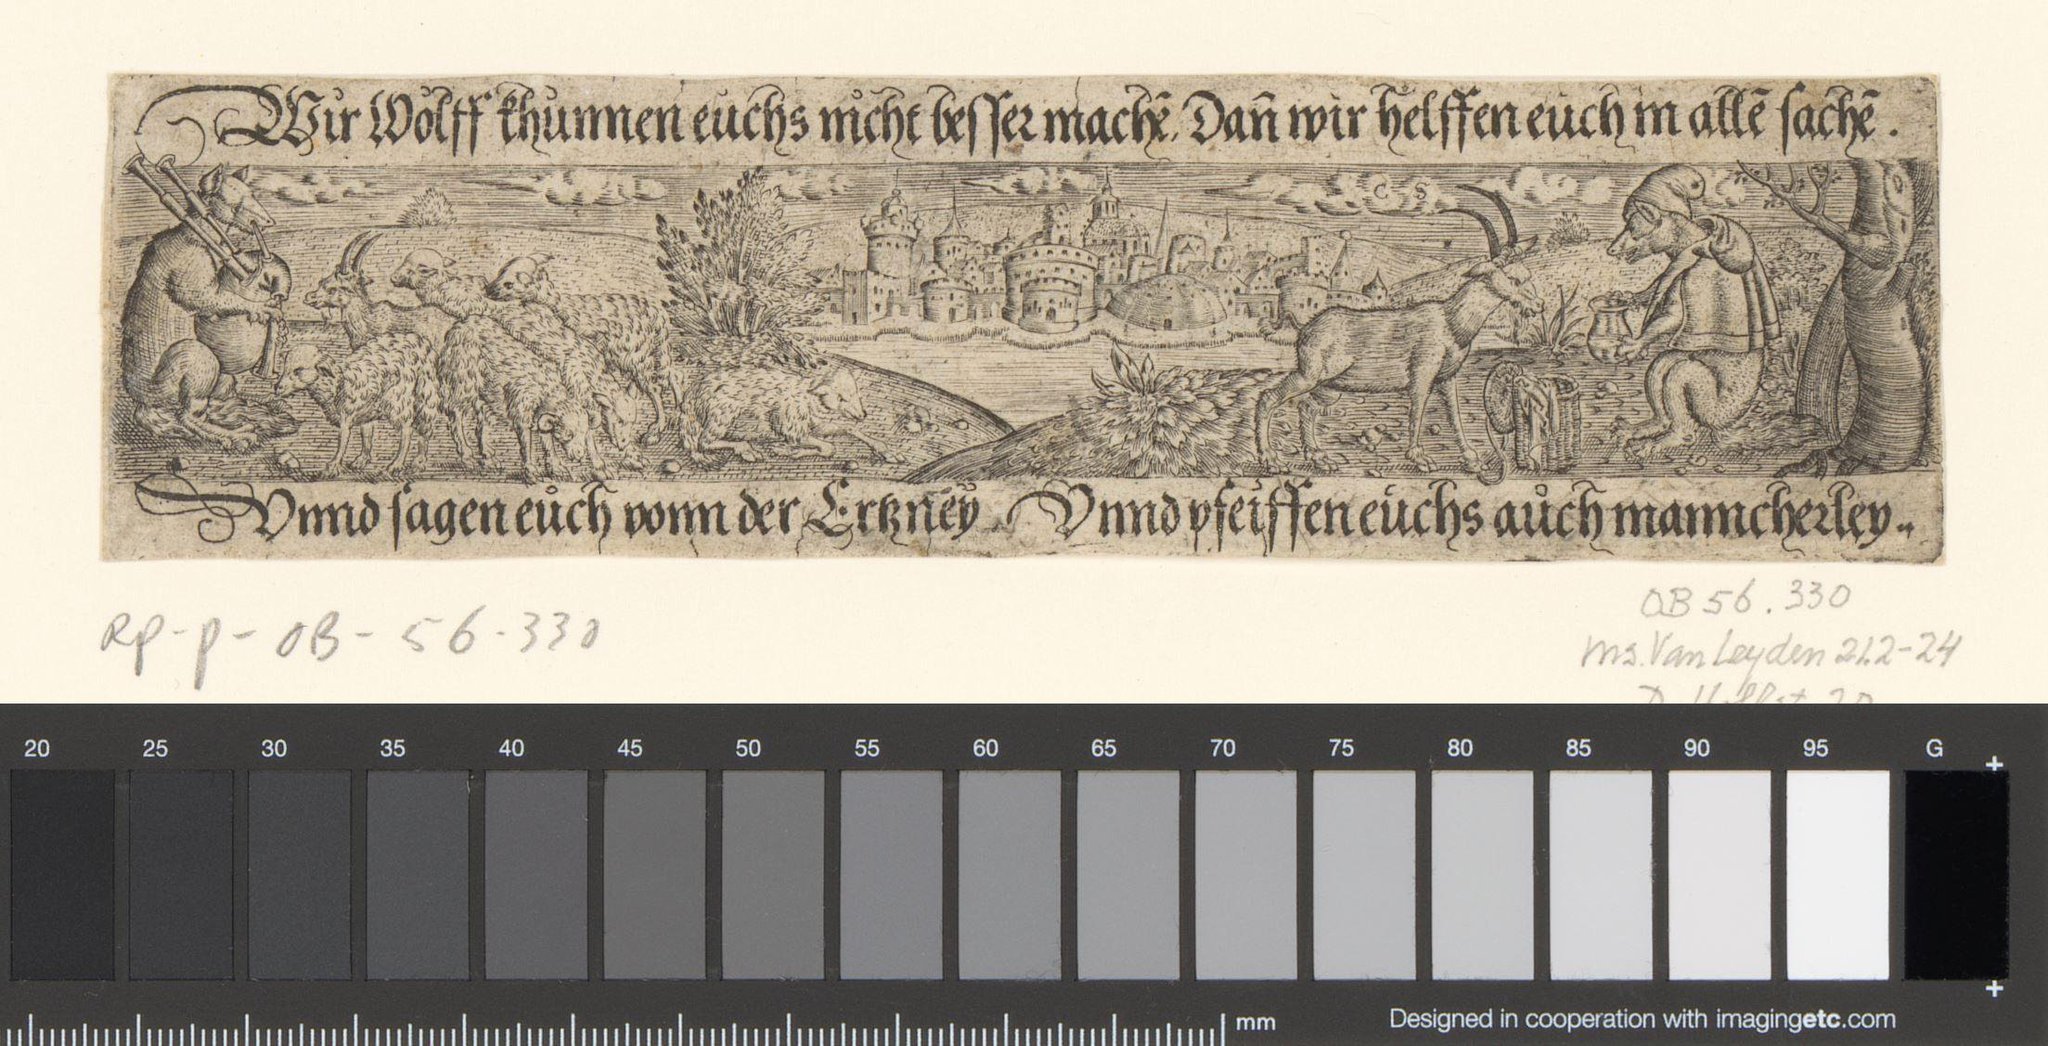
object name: print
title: Wolf verleidt geiten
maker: conrad saldörffer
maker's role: print maker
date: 1563-1583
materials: paper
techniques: etching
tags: bagpipe, musette, goat, beasts of prey, predatory animals: wolf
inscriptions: collector's mark: Lugt 2228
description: Onderdeel van een serie satirische prenten met dieren, waarvan de complete hoeveelheid onbekend is.